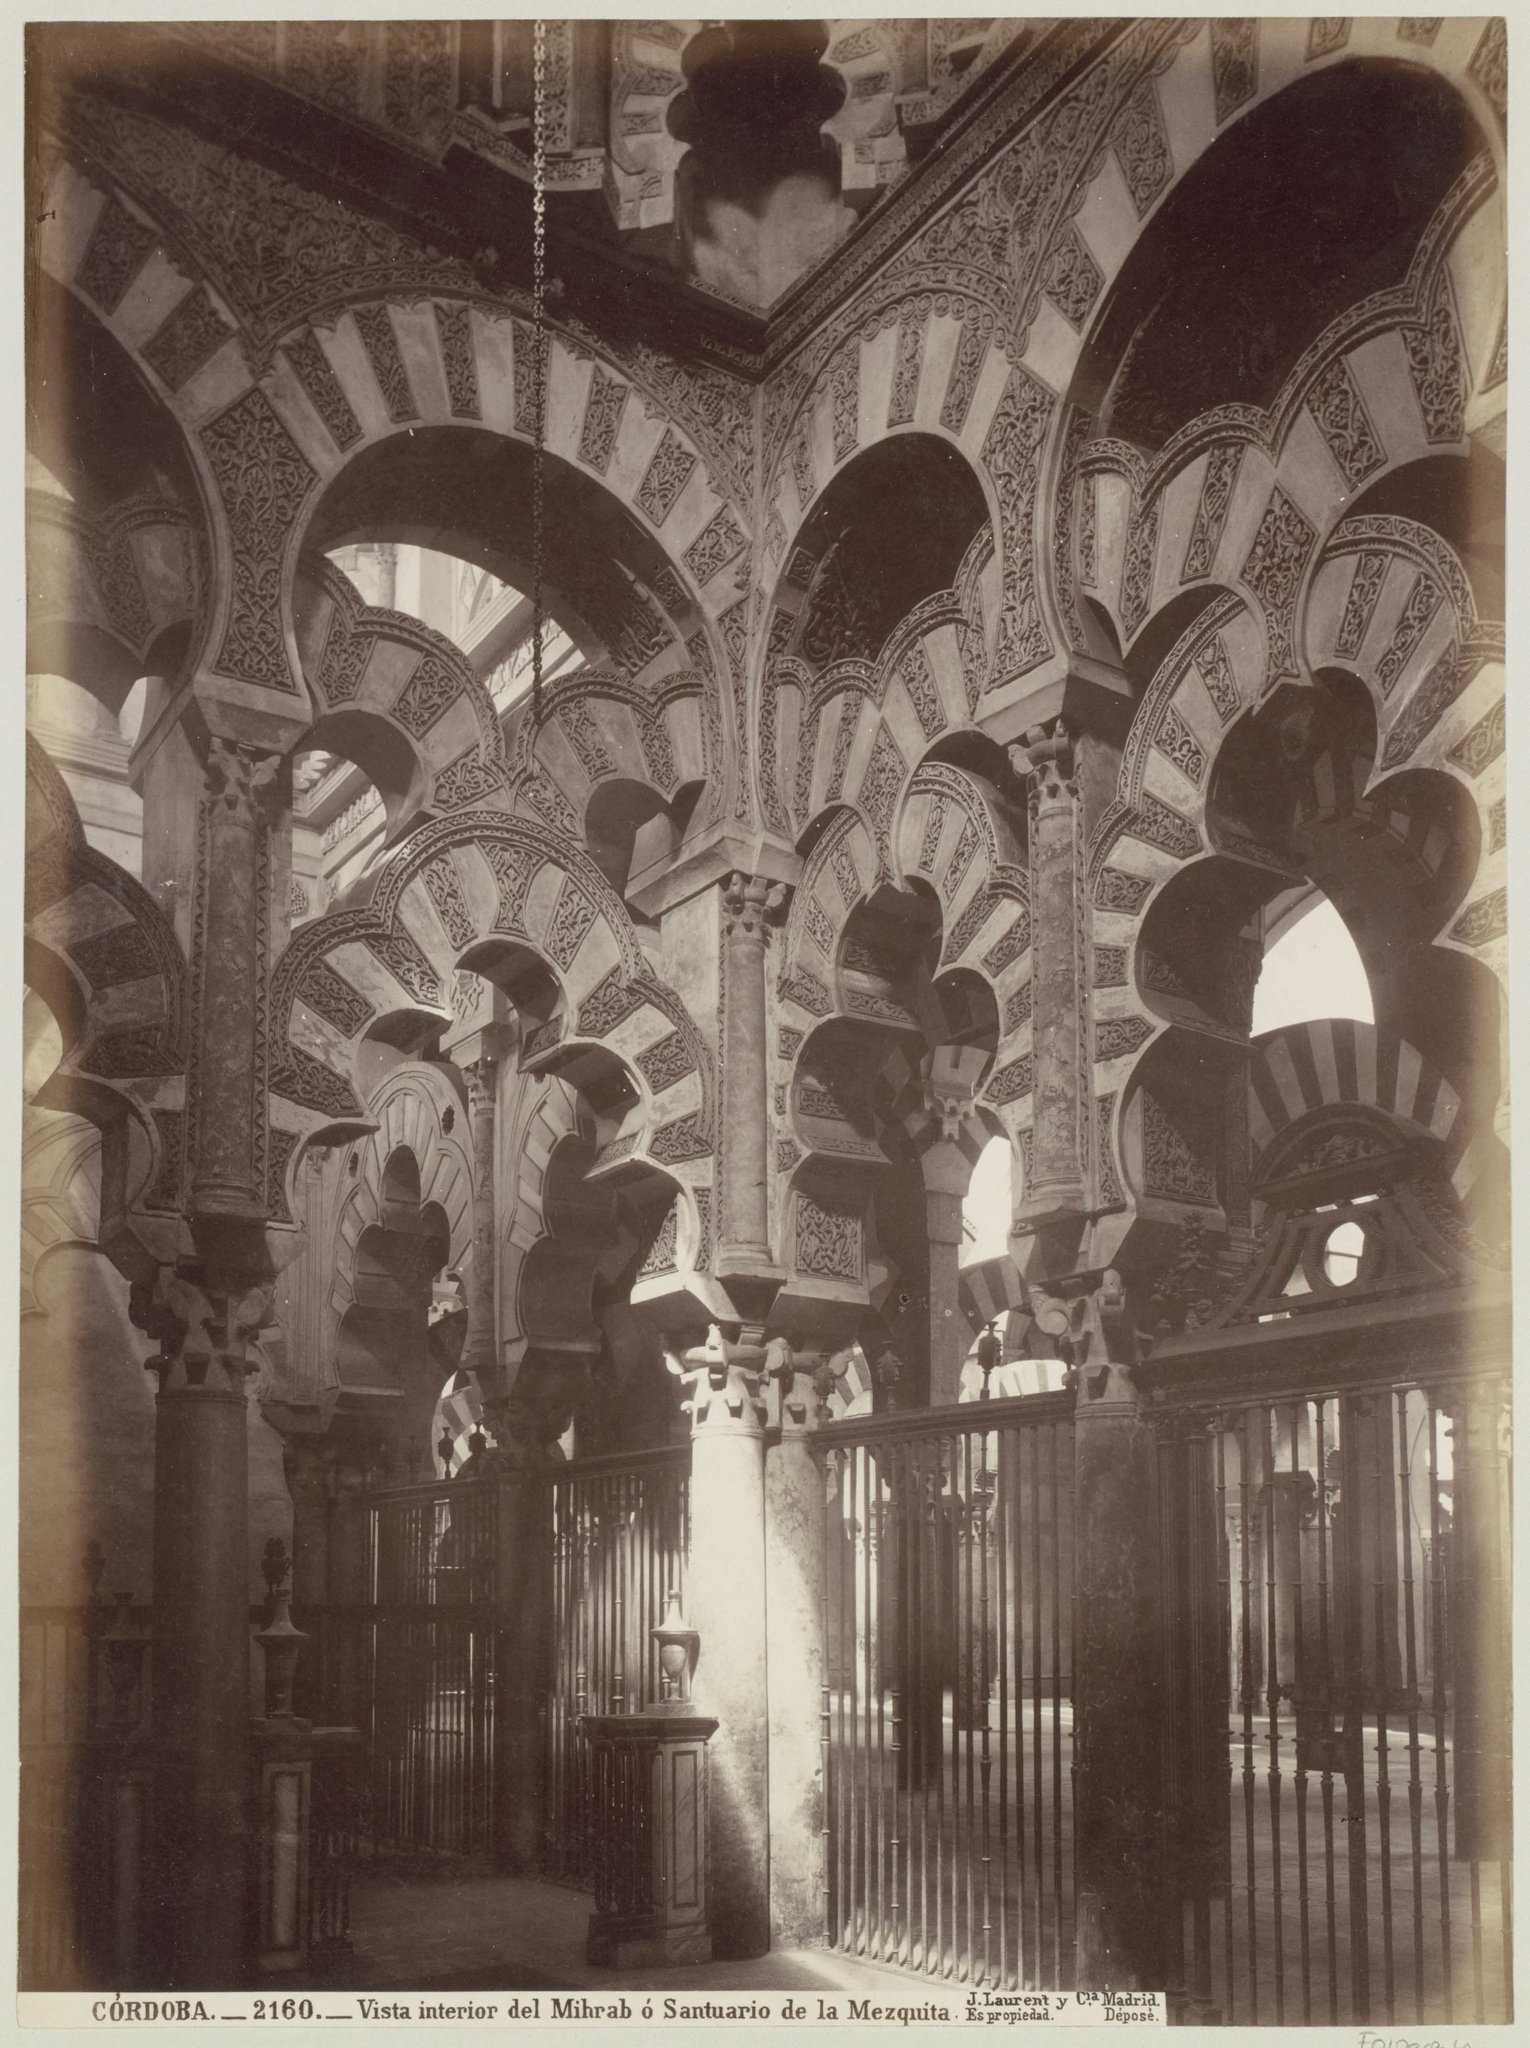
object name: photograph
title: CORDOBA - Vista interior del Mihrab ó Santuario de la Mezquita.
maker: juan laurent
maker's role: publisher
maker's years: 1816-1896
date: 1857-1880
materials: cardboard, paper, photographic support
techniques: albumen print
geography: mezquita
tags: interior of church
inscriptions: negative number: ‘2160’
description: Onderdeel van Reisalbum met foto's van bezienswaardigheden in Spanje en Marokko.